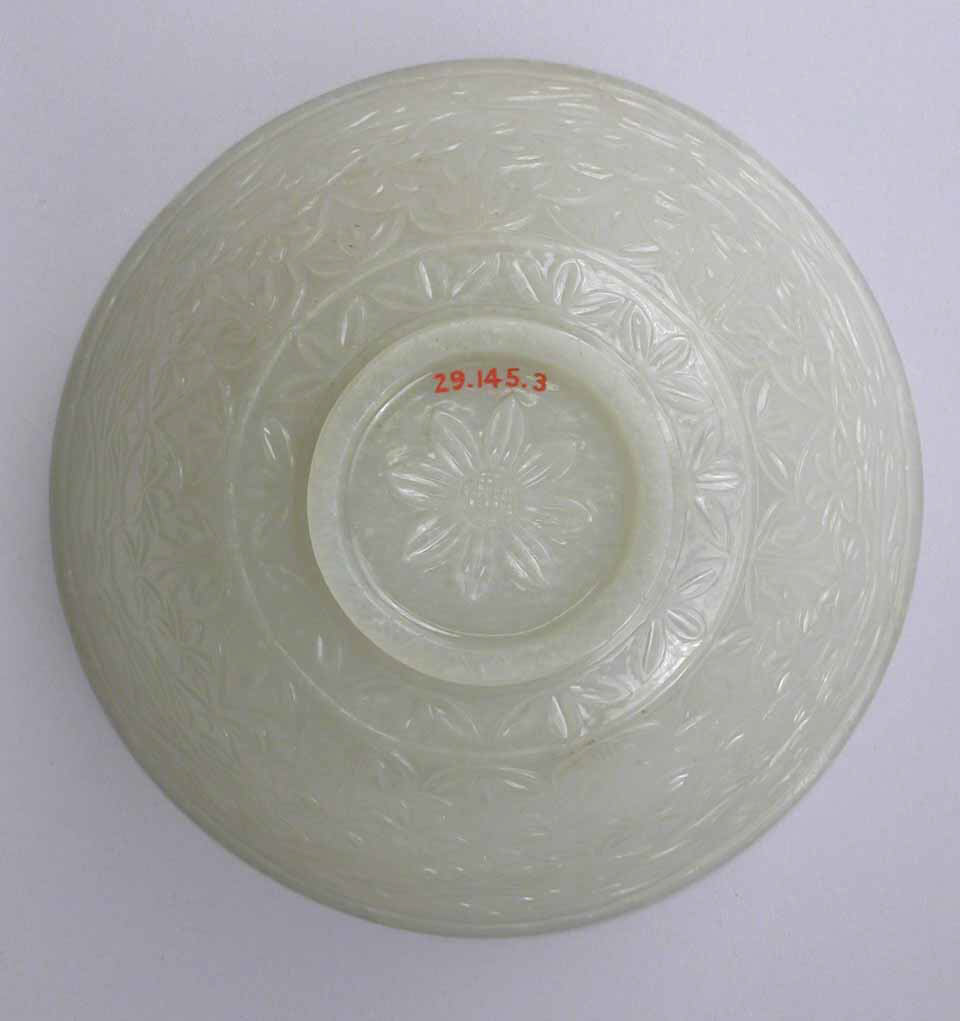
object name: bowl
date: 1700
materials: jade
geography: turkey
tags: flowers